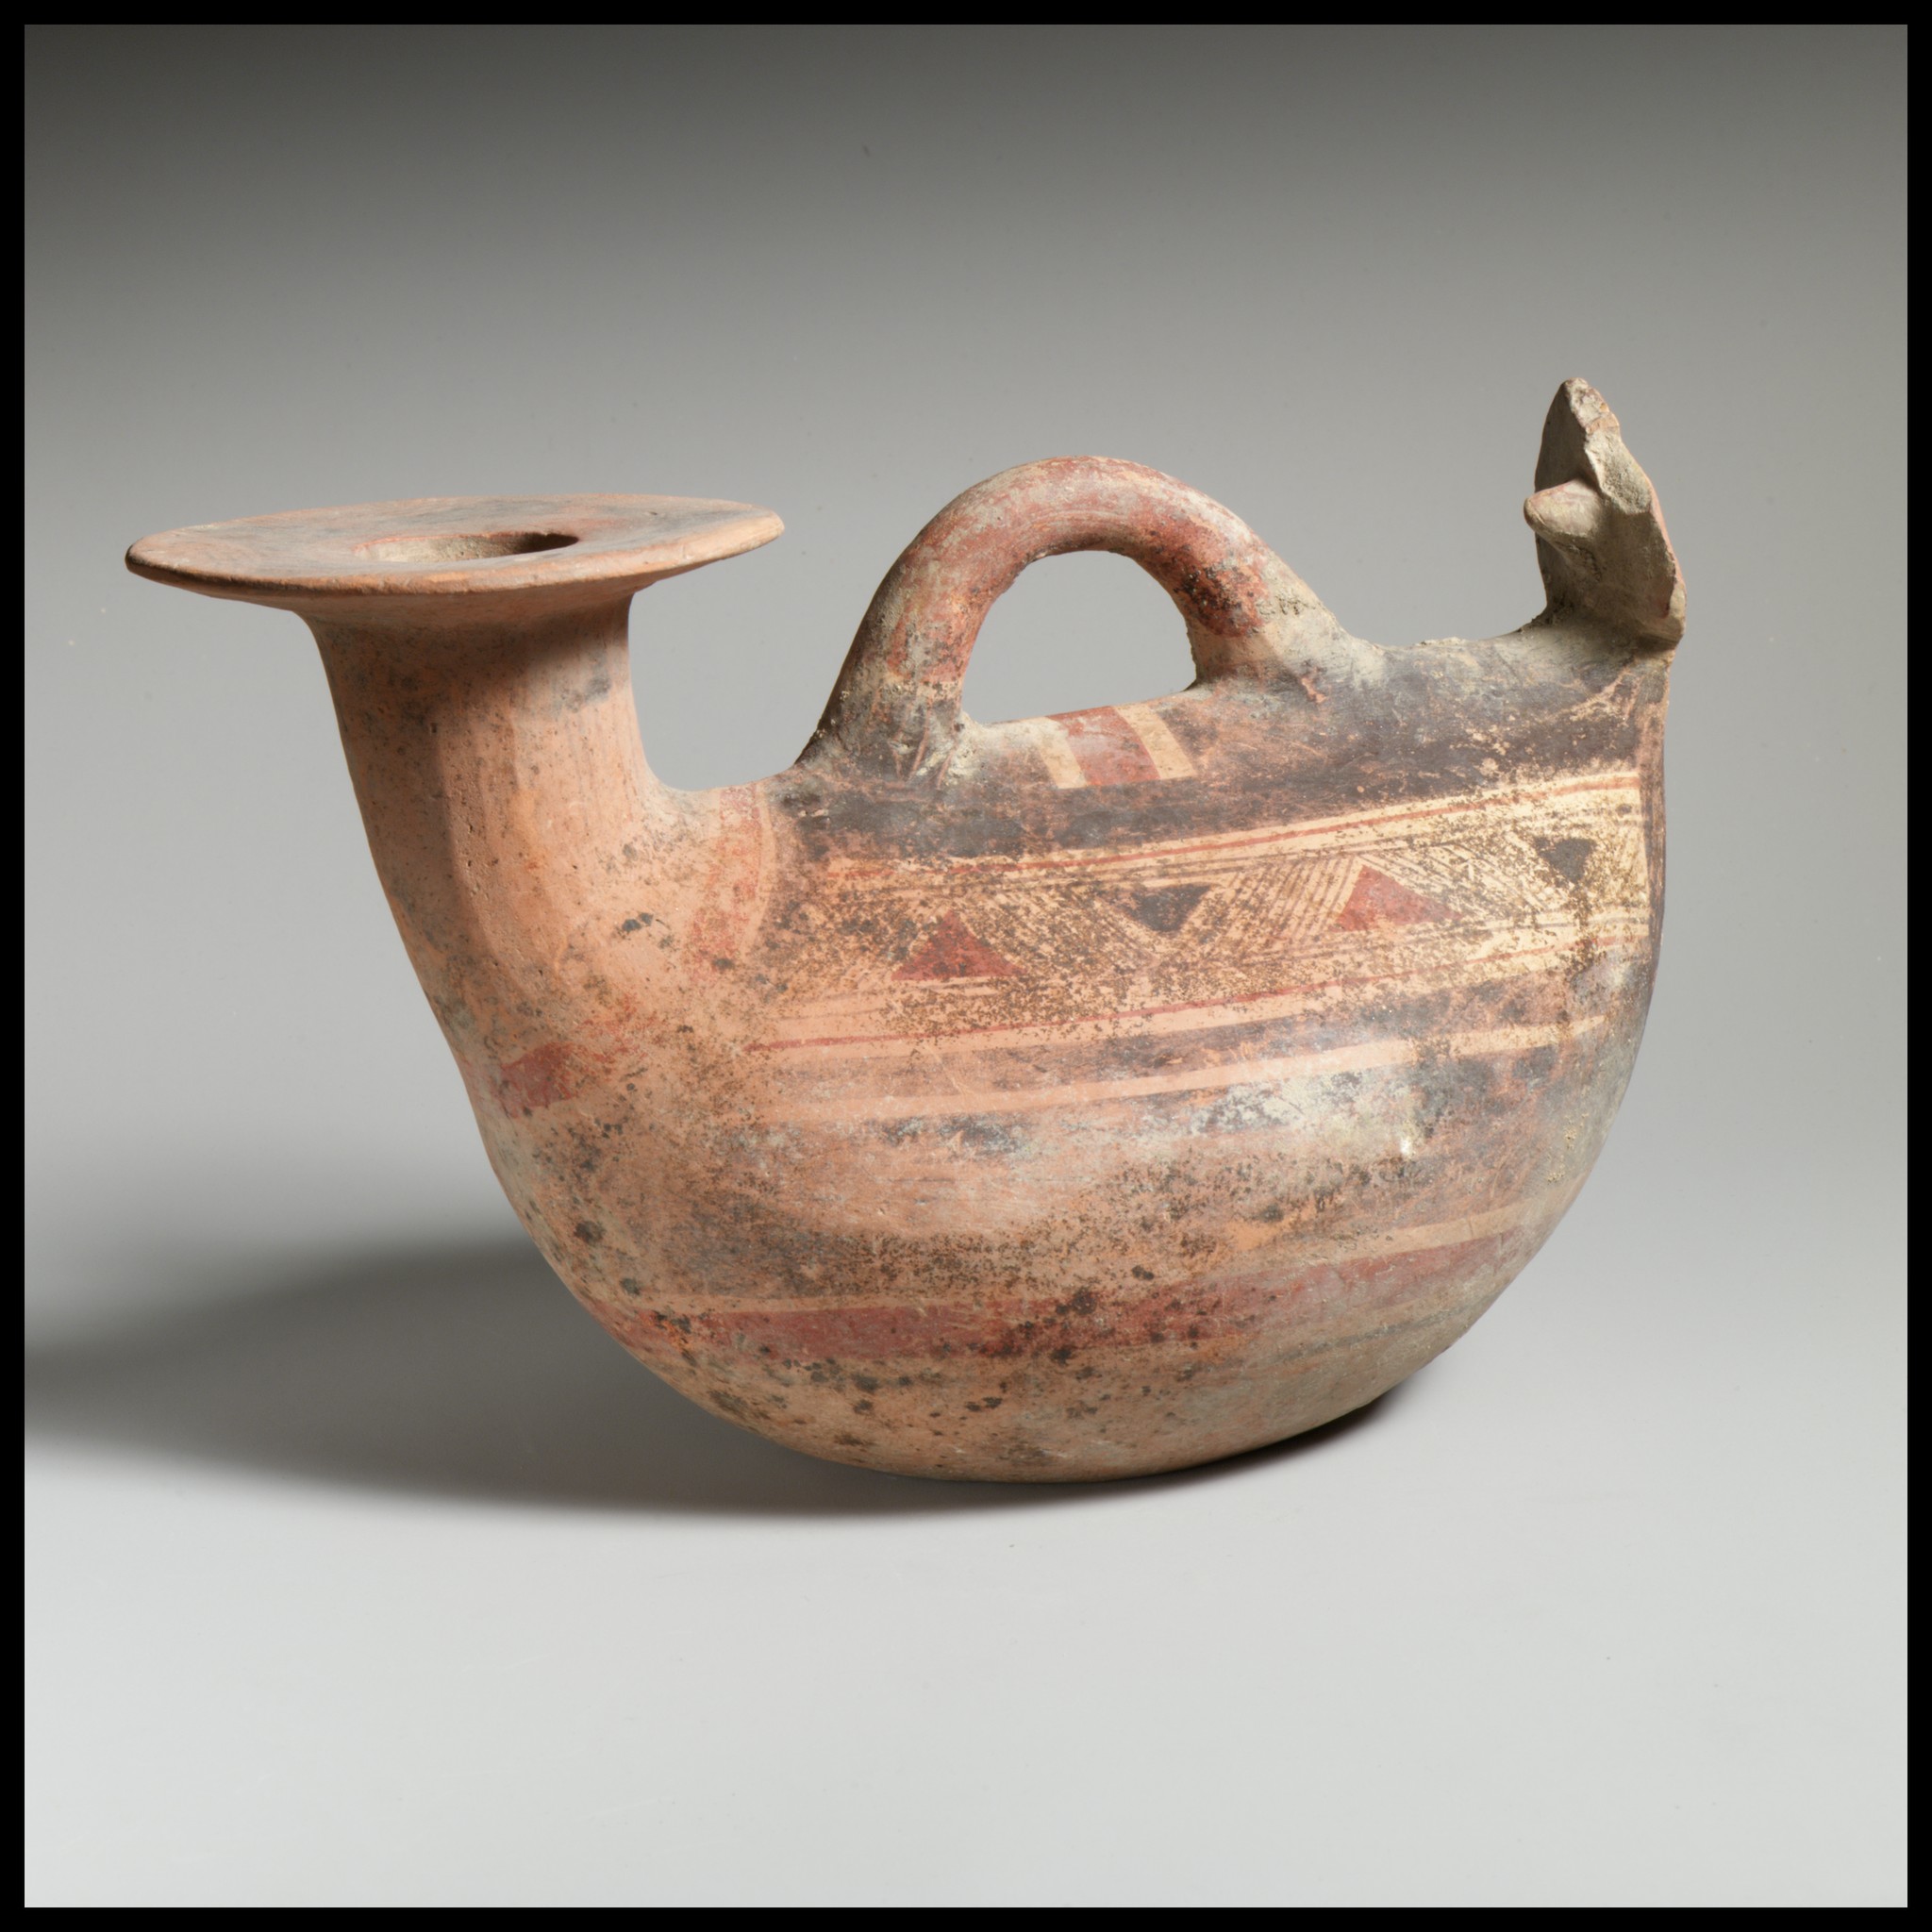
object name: askos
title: Terracotta askos (flask with a spout and handle over the top)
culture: italic, daunian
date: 400-301 BCE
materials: terracotta